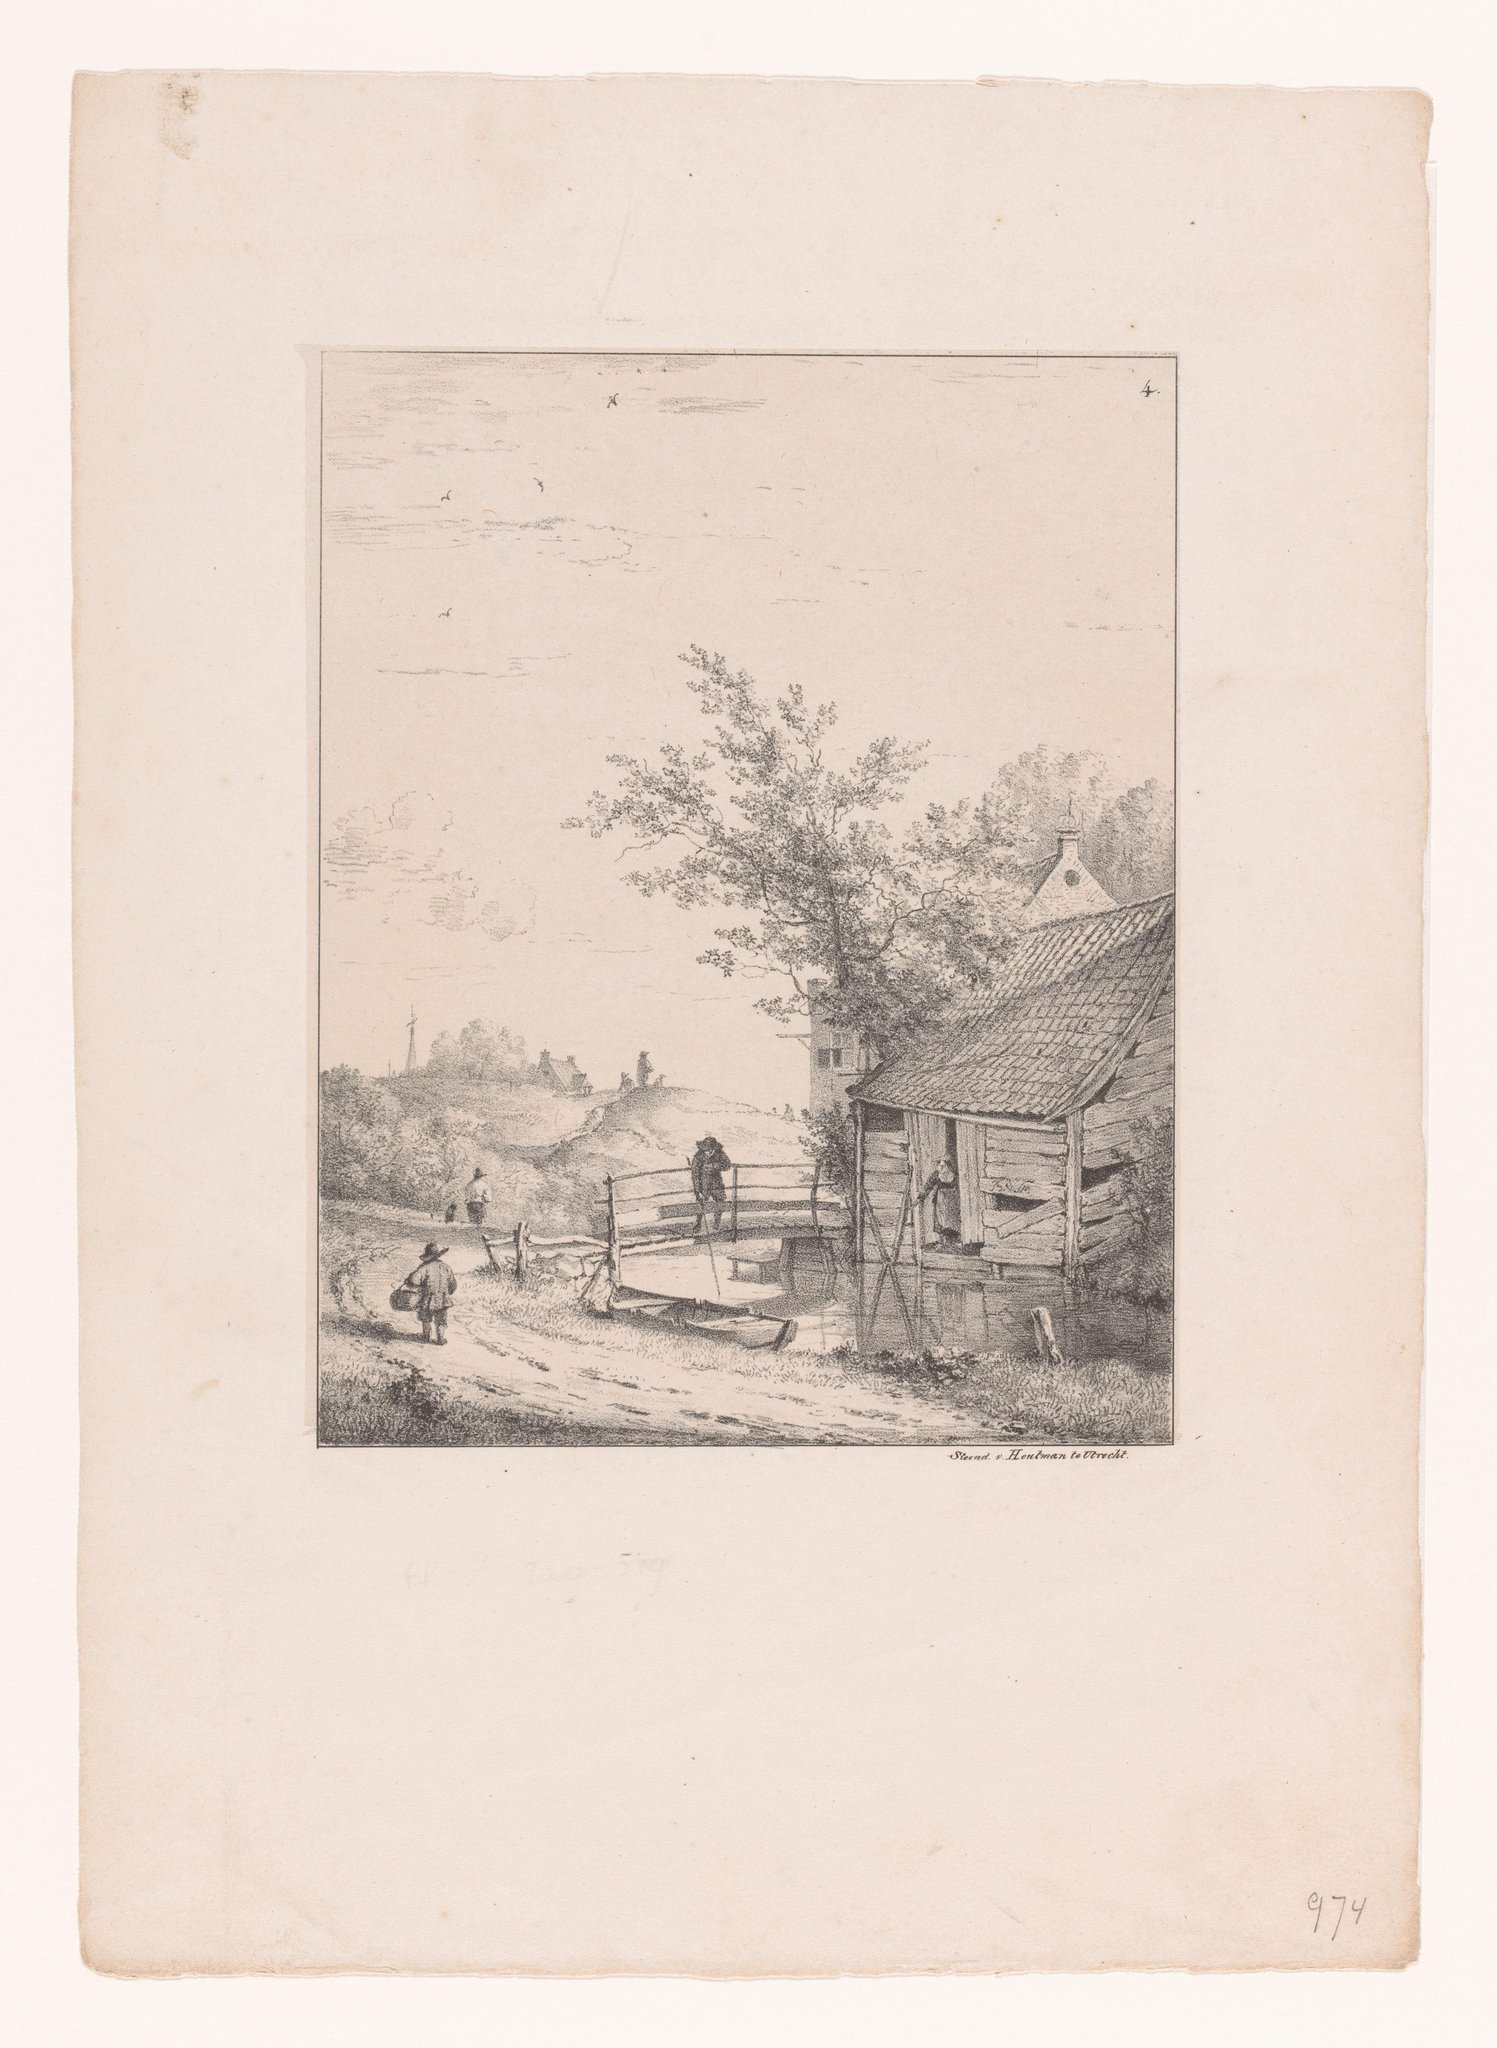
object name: print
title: Landschappen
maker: bruno van straaten (i)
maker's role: draughtsman, print maker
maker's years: 1786-1870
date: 1858-1859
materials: paper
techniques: lithograph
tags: barn, river, bridge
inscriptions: collector's mark: Lugt 2228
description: Landschap met rivier. Over de rivier een houten brug waarop een man staat te vissen. Rechts daarvan een schuur met een vrouw in de deuropening. Links een pad waarover een figuur met mand in de arm loopt. Links in de verte heuvels en een boerderij.